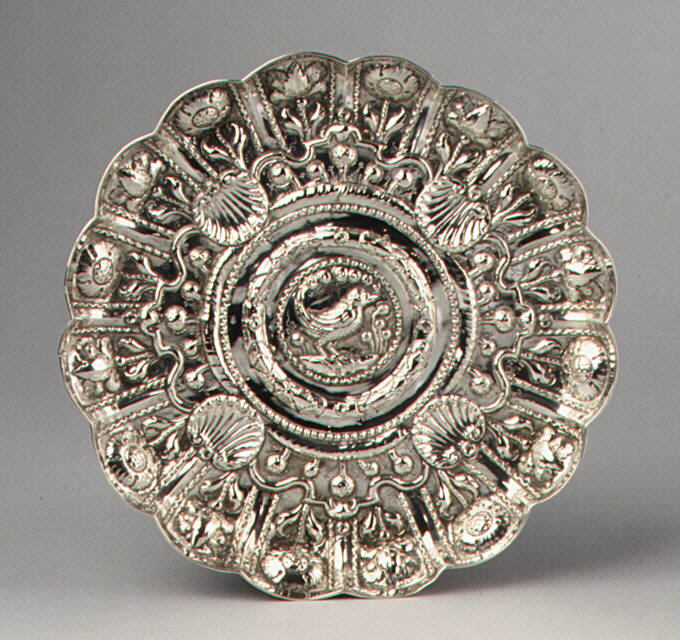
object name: dish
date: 1801-1833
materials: silver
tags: birds,flowers